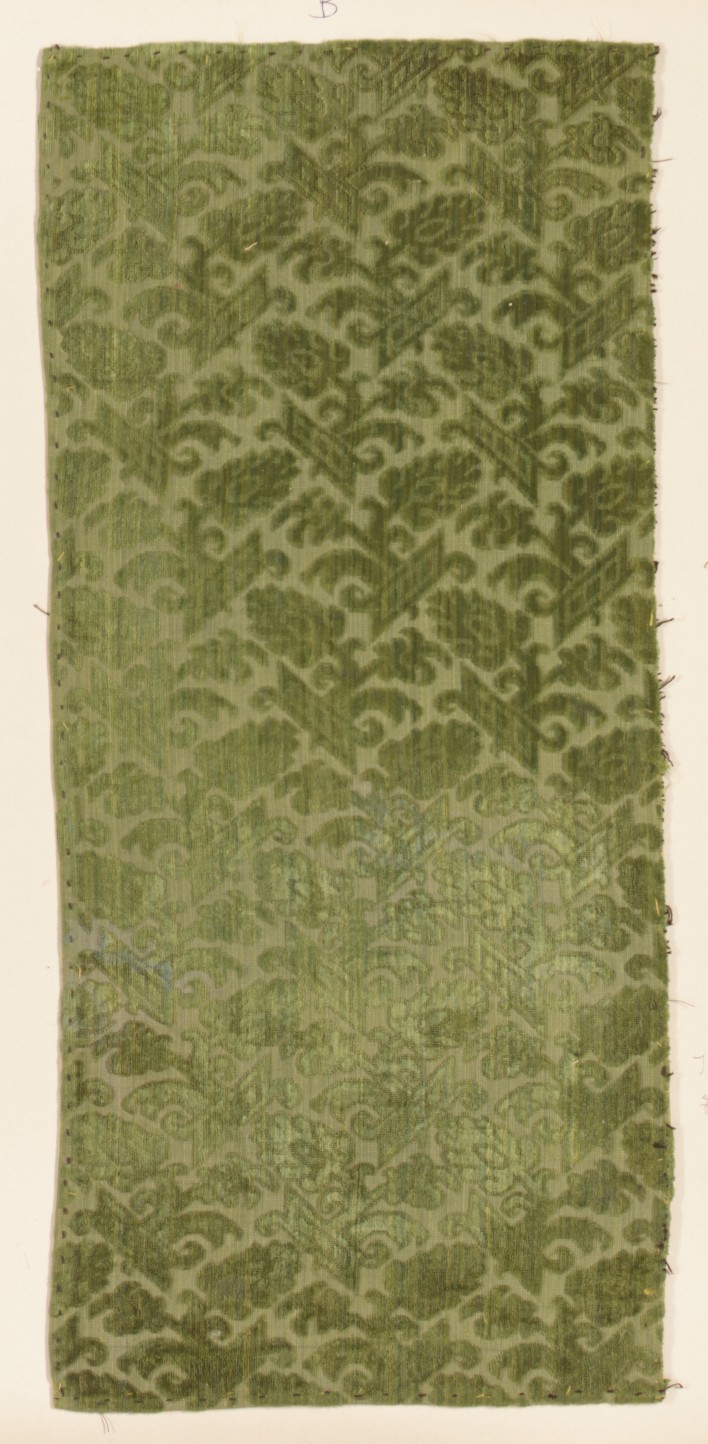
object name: fragment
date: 1501-1600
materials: silk